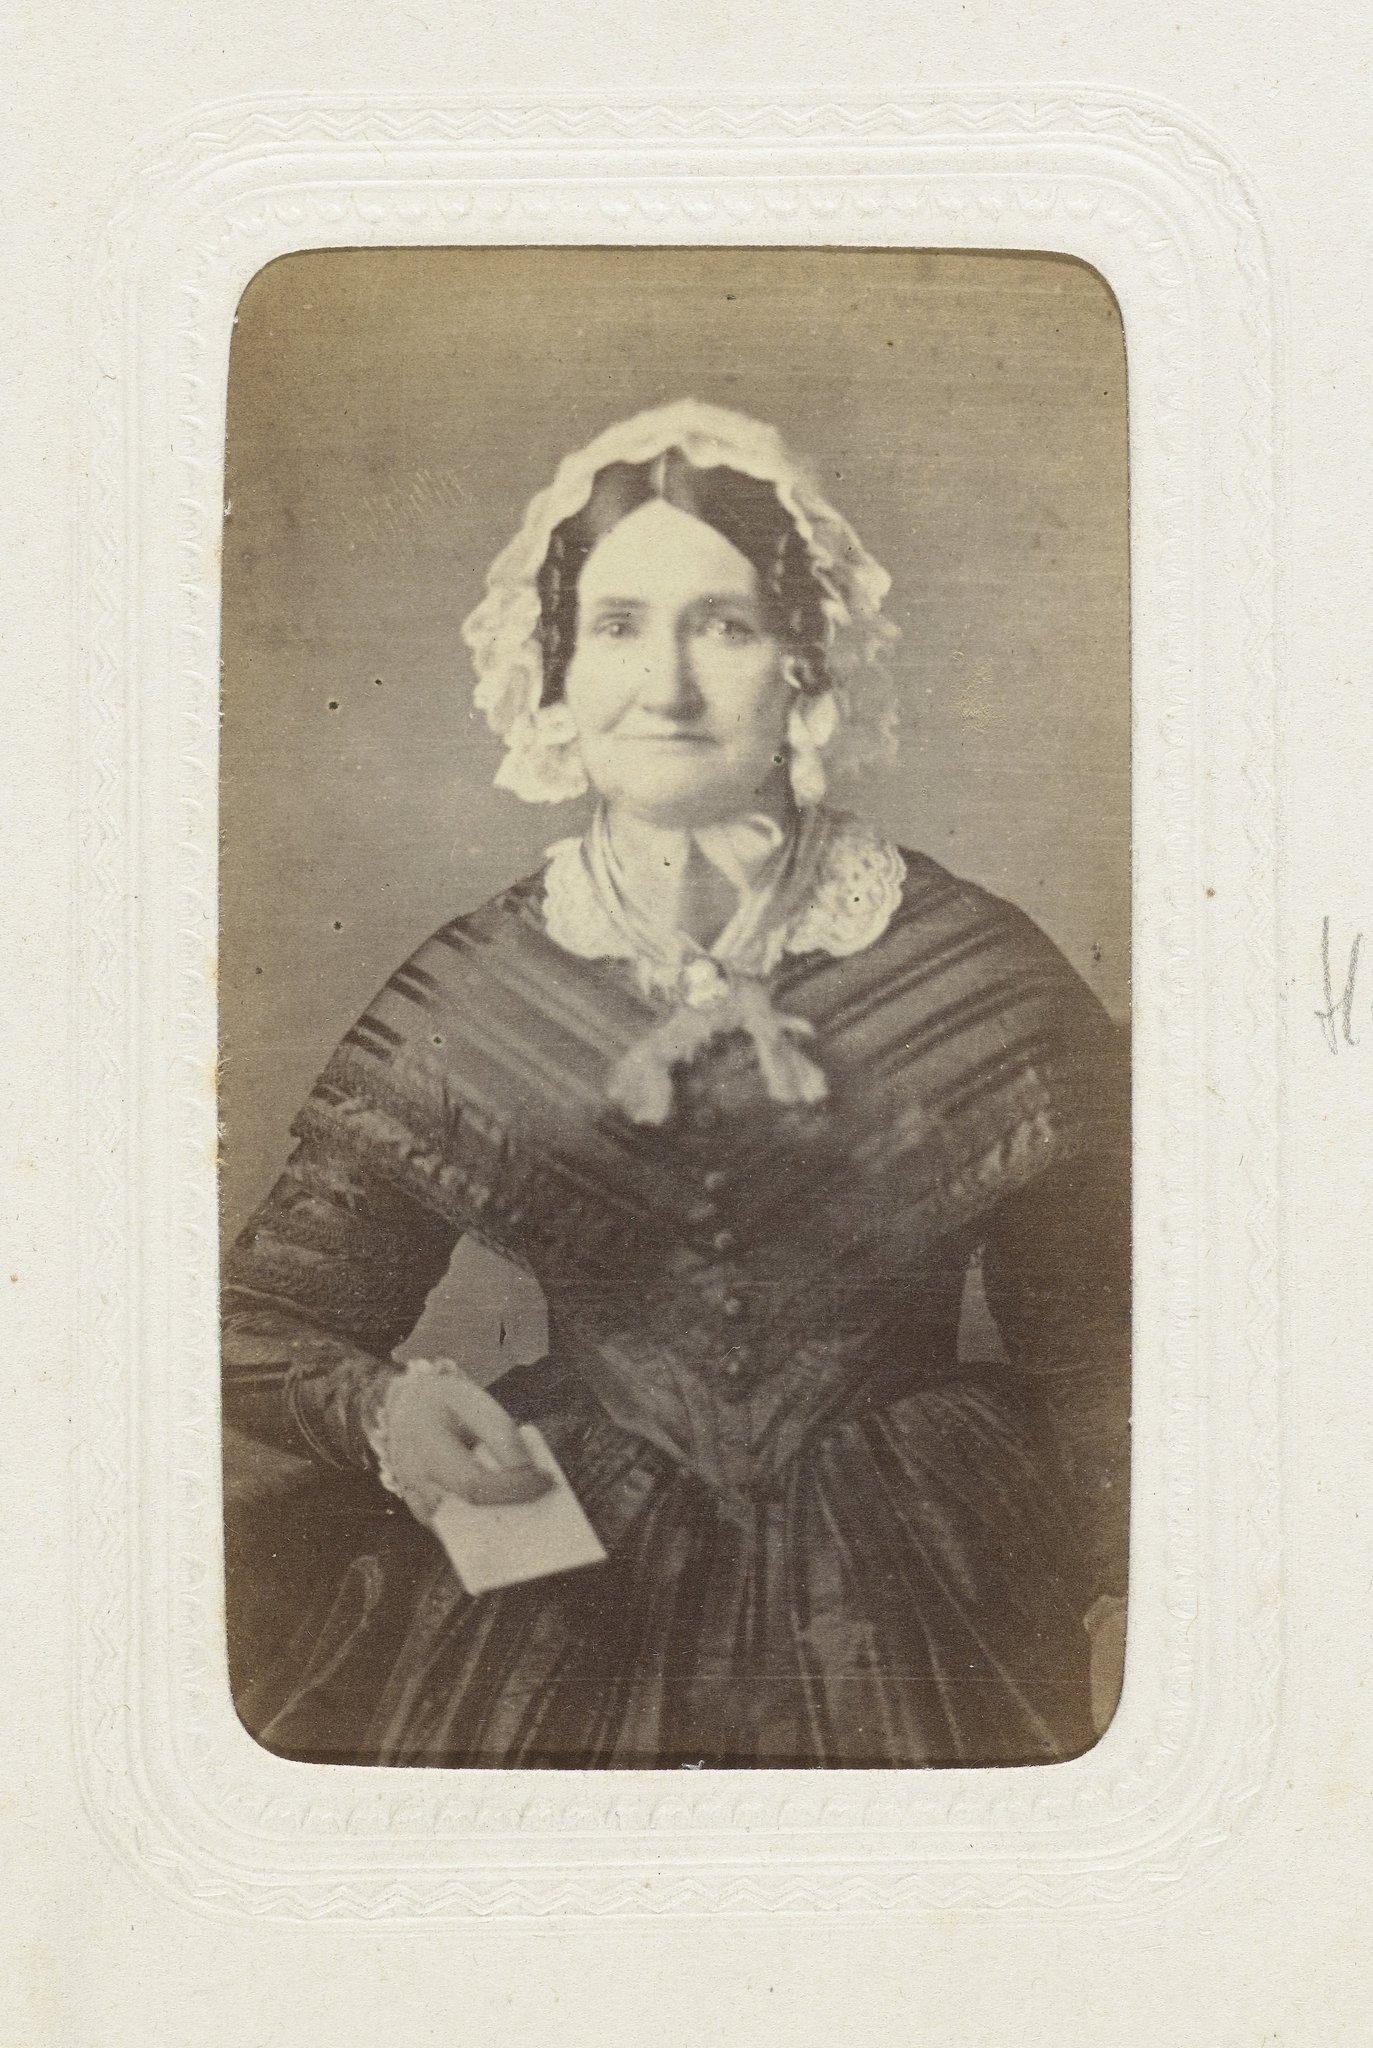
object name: carte de visite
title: Studioportret van een oudere vrouw in een lange, bolle zwarte jurk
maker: i.h. hoffmeister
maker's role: fotograaf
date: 1863-1866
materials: cardboard, paper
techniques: albumen print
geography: amsterdam